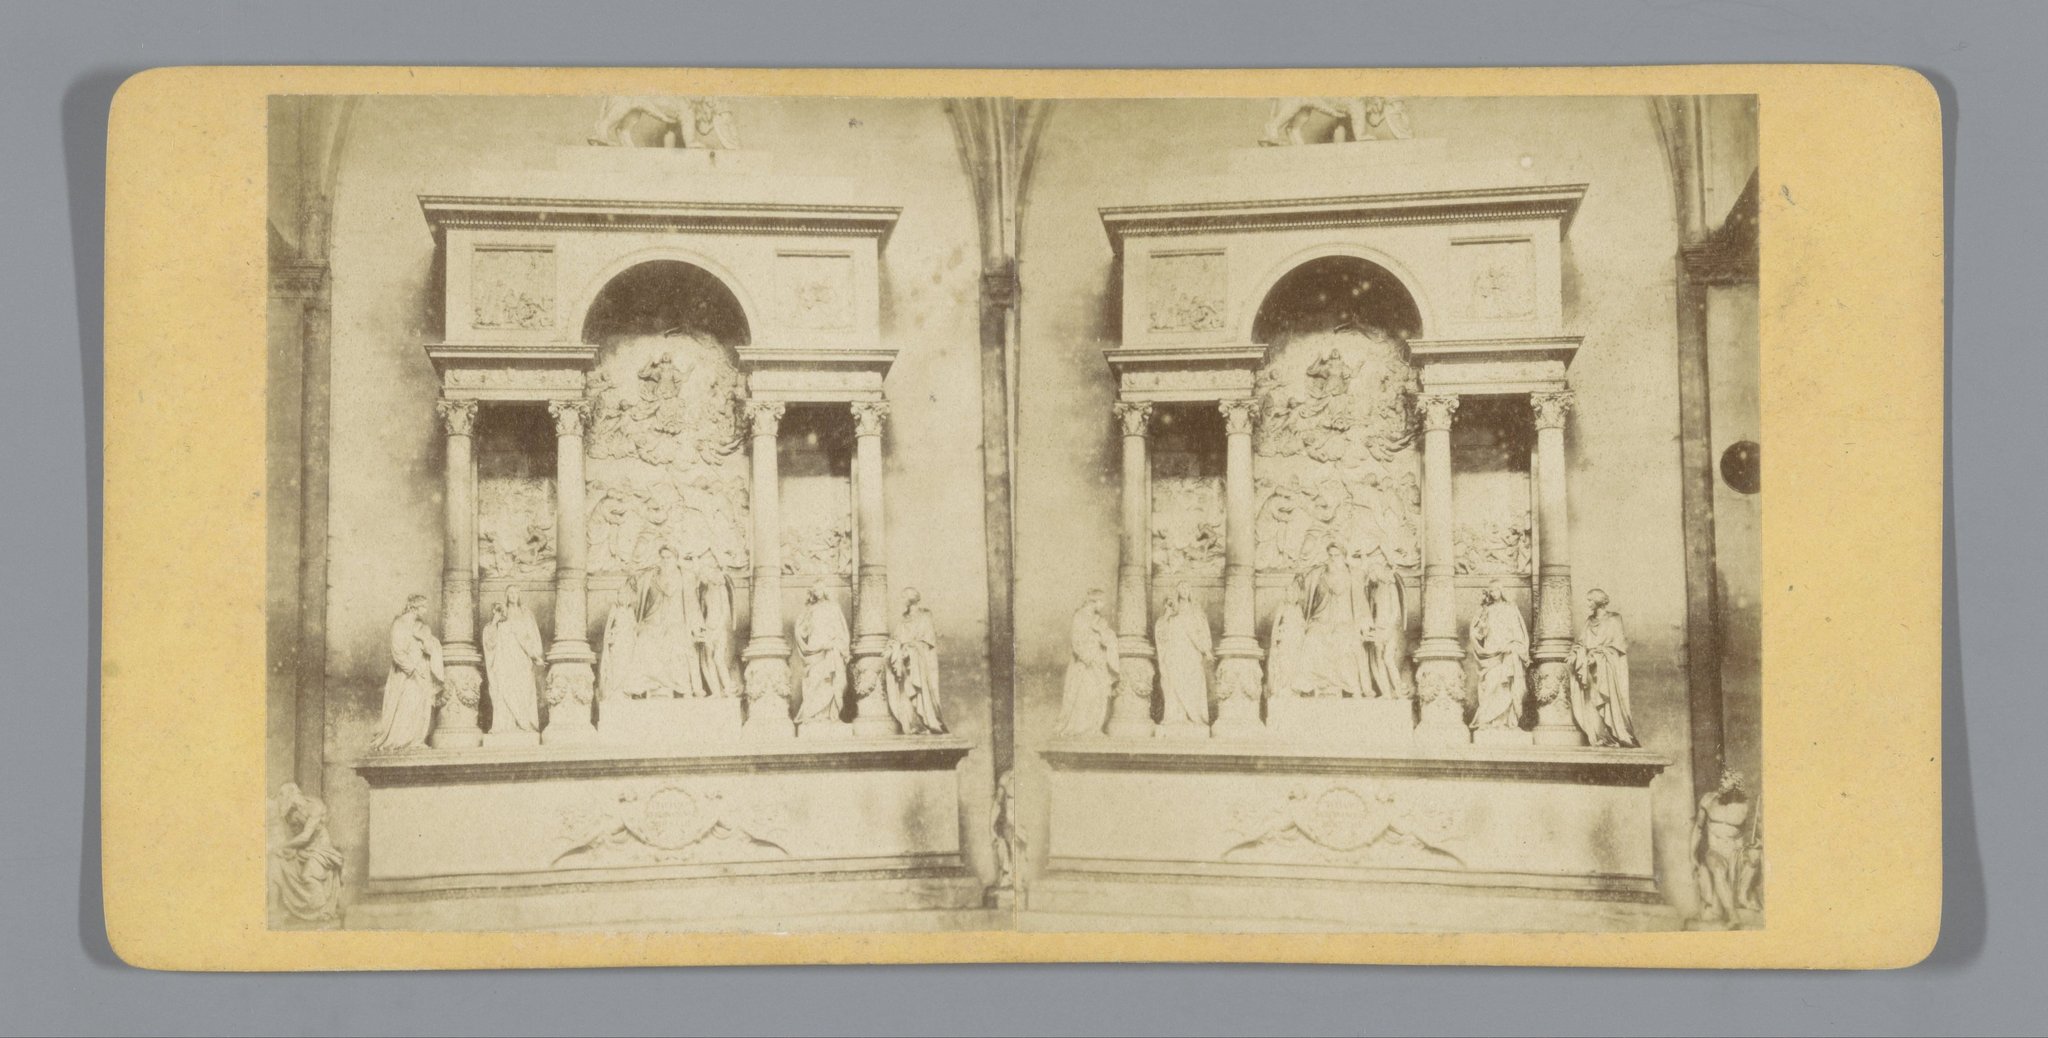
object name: stereograph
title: Grafmonument van Titiaan in de Basilica di Santa Maria Gloriosa dei Frari te Venetië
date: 1860-1880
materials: cardboard, photographic support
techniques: albumen print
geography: basilica di santa maria gloriosa dei frari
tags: interior of church, grave-building, monumental tomb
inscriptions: name: ‘C. Coen e Figlio Venezia Trieste’, inscription: ‘Monumento Tiziano’